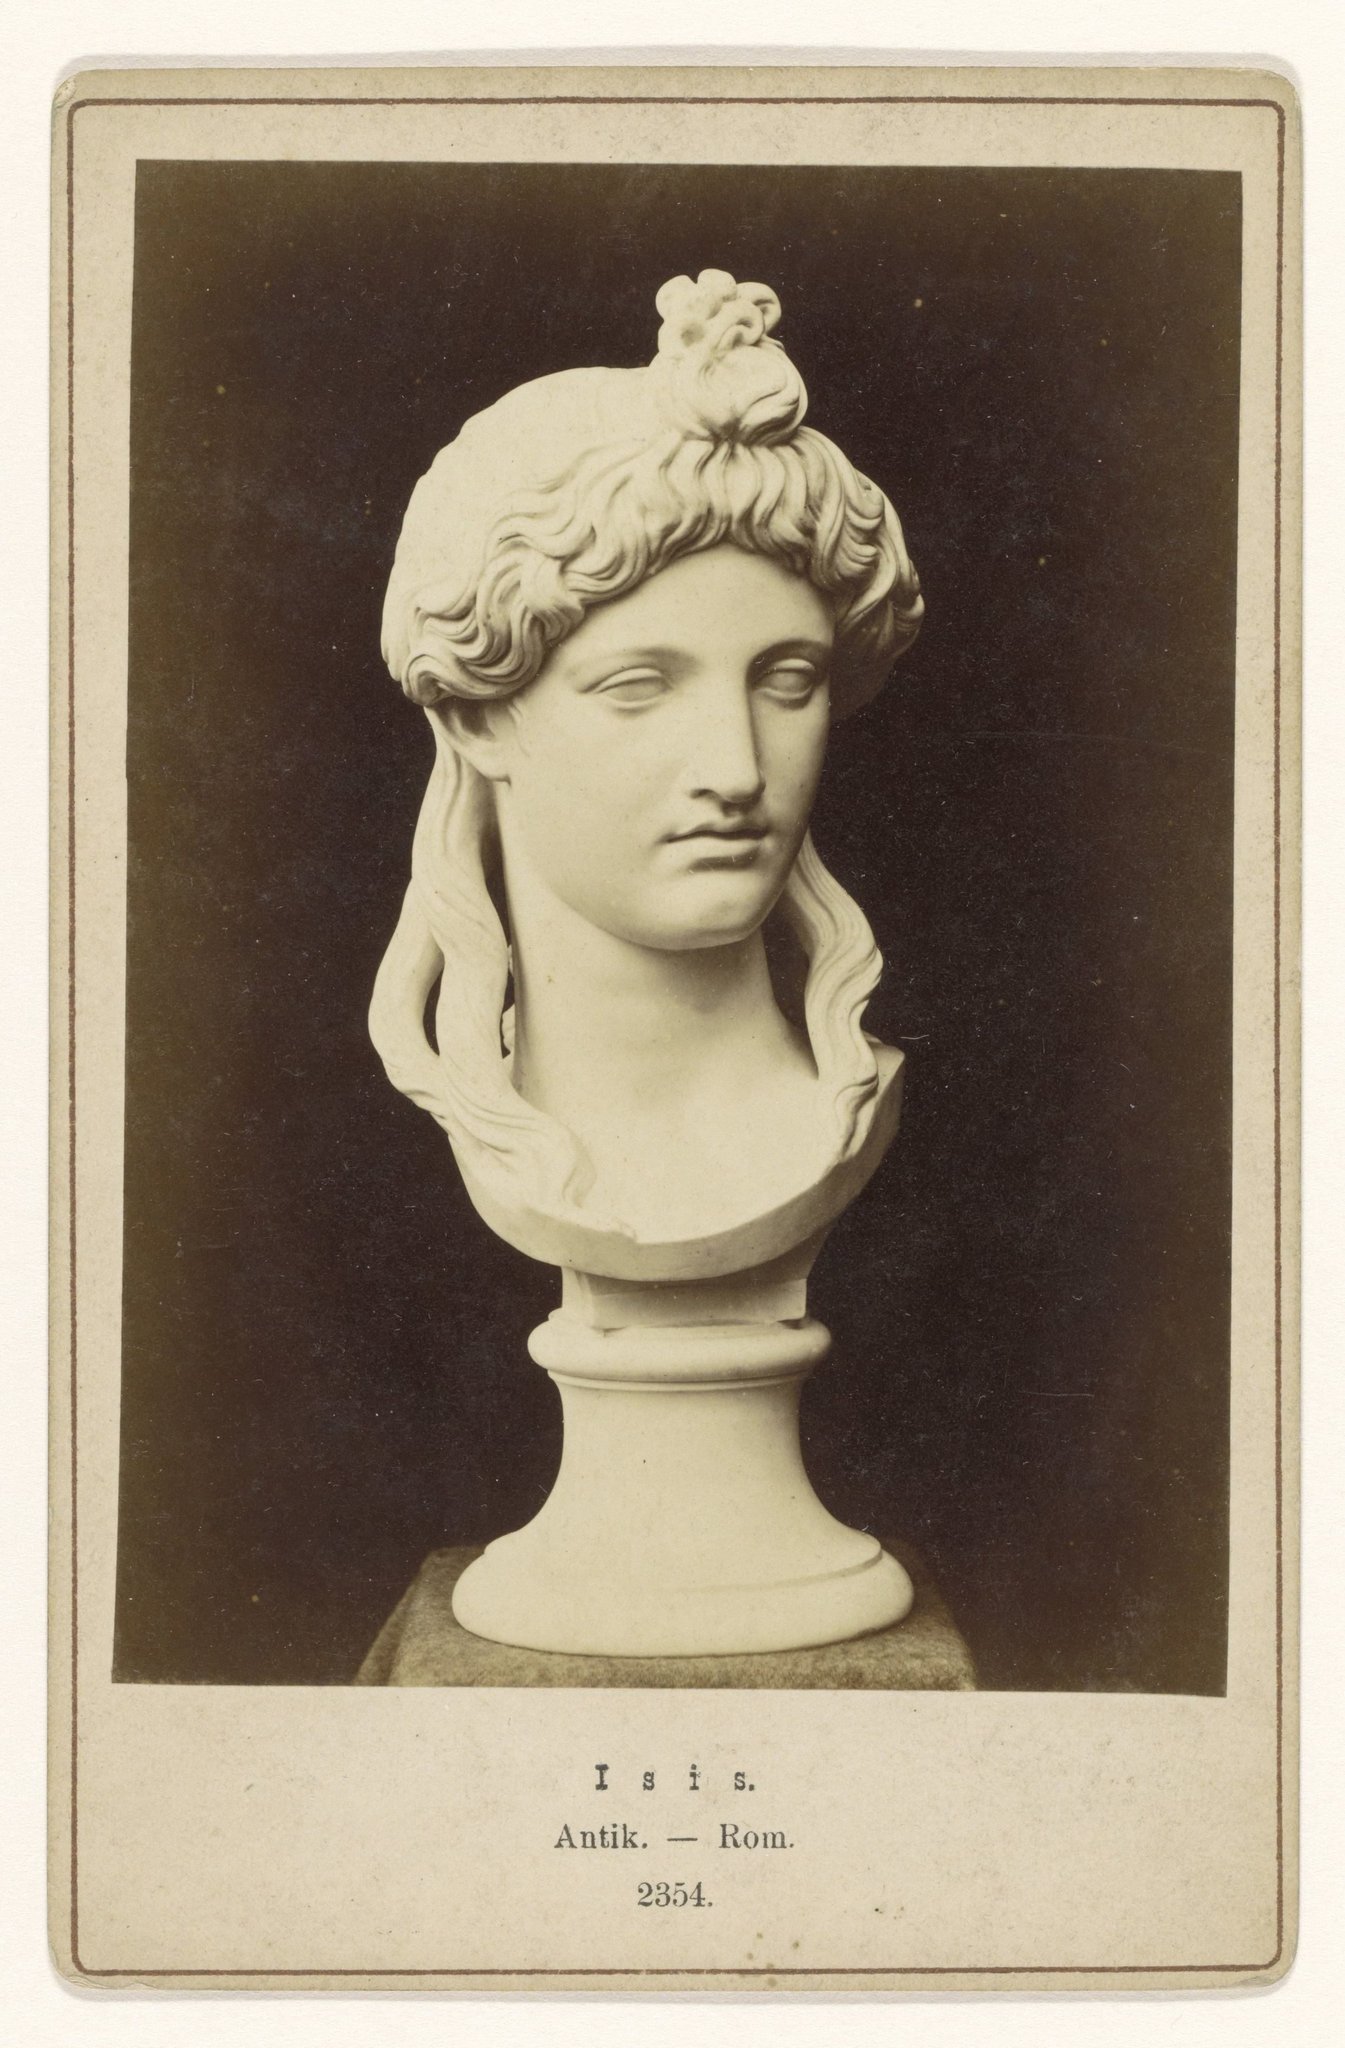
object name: cabinet photograph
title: Antiken. 12 Photographien nach Antiken, Sculpturen und Statuen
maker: s.p. christmann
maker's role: publisher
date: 1870-1890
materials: cardboard, paper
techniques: albumen print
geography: berlin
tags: piece of sculpture, reproduction of a piece of sculpture, isis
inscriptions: collector's mark: ‘Vosmaer’, title: ‘Isis./ Antik. - Rom./ 2354’